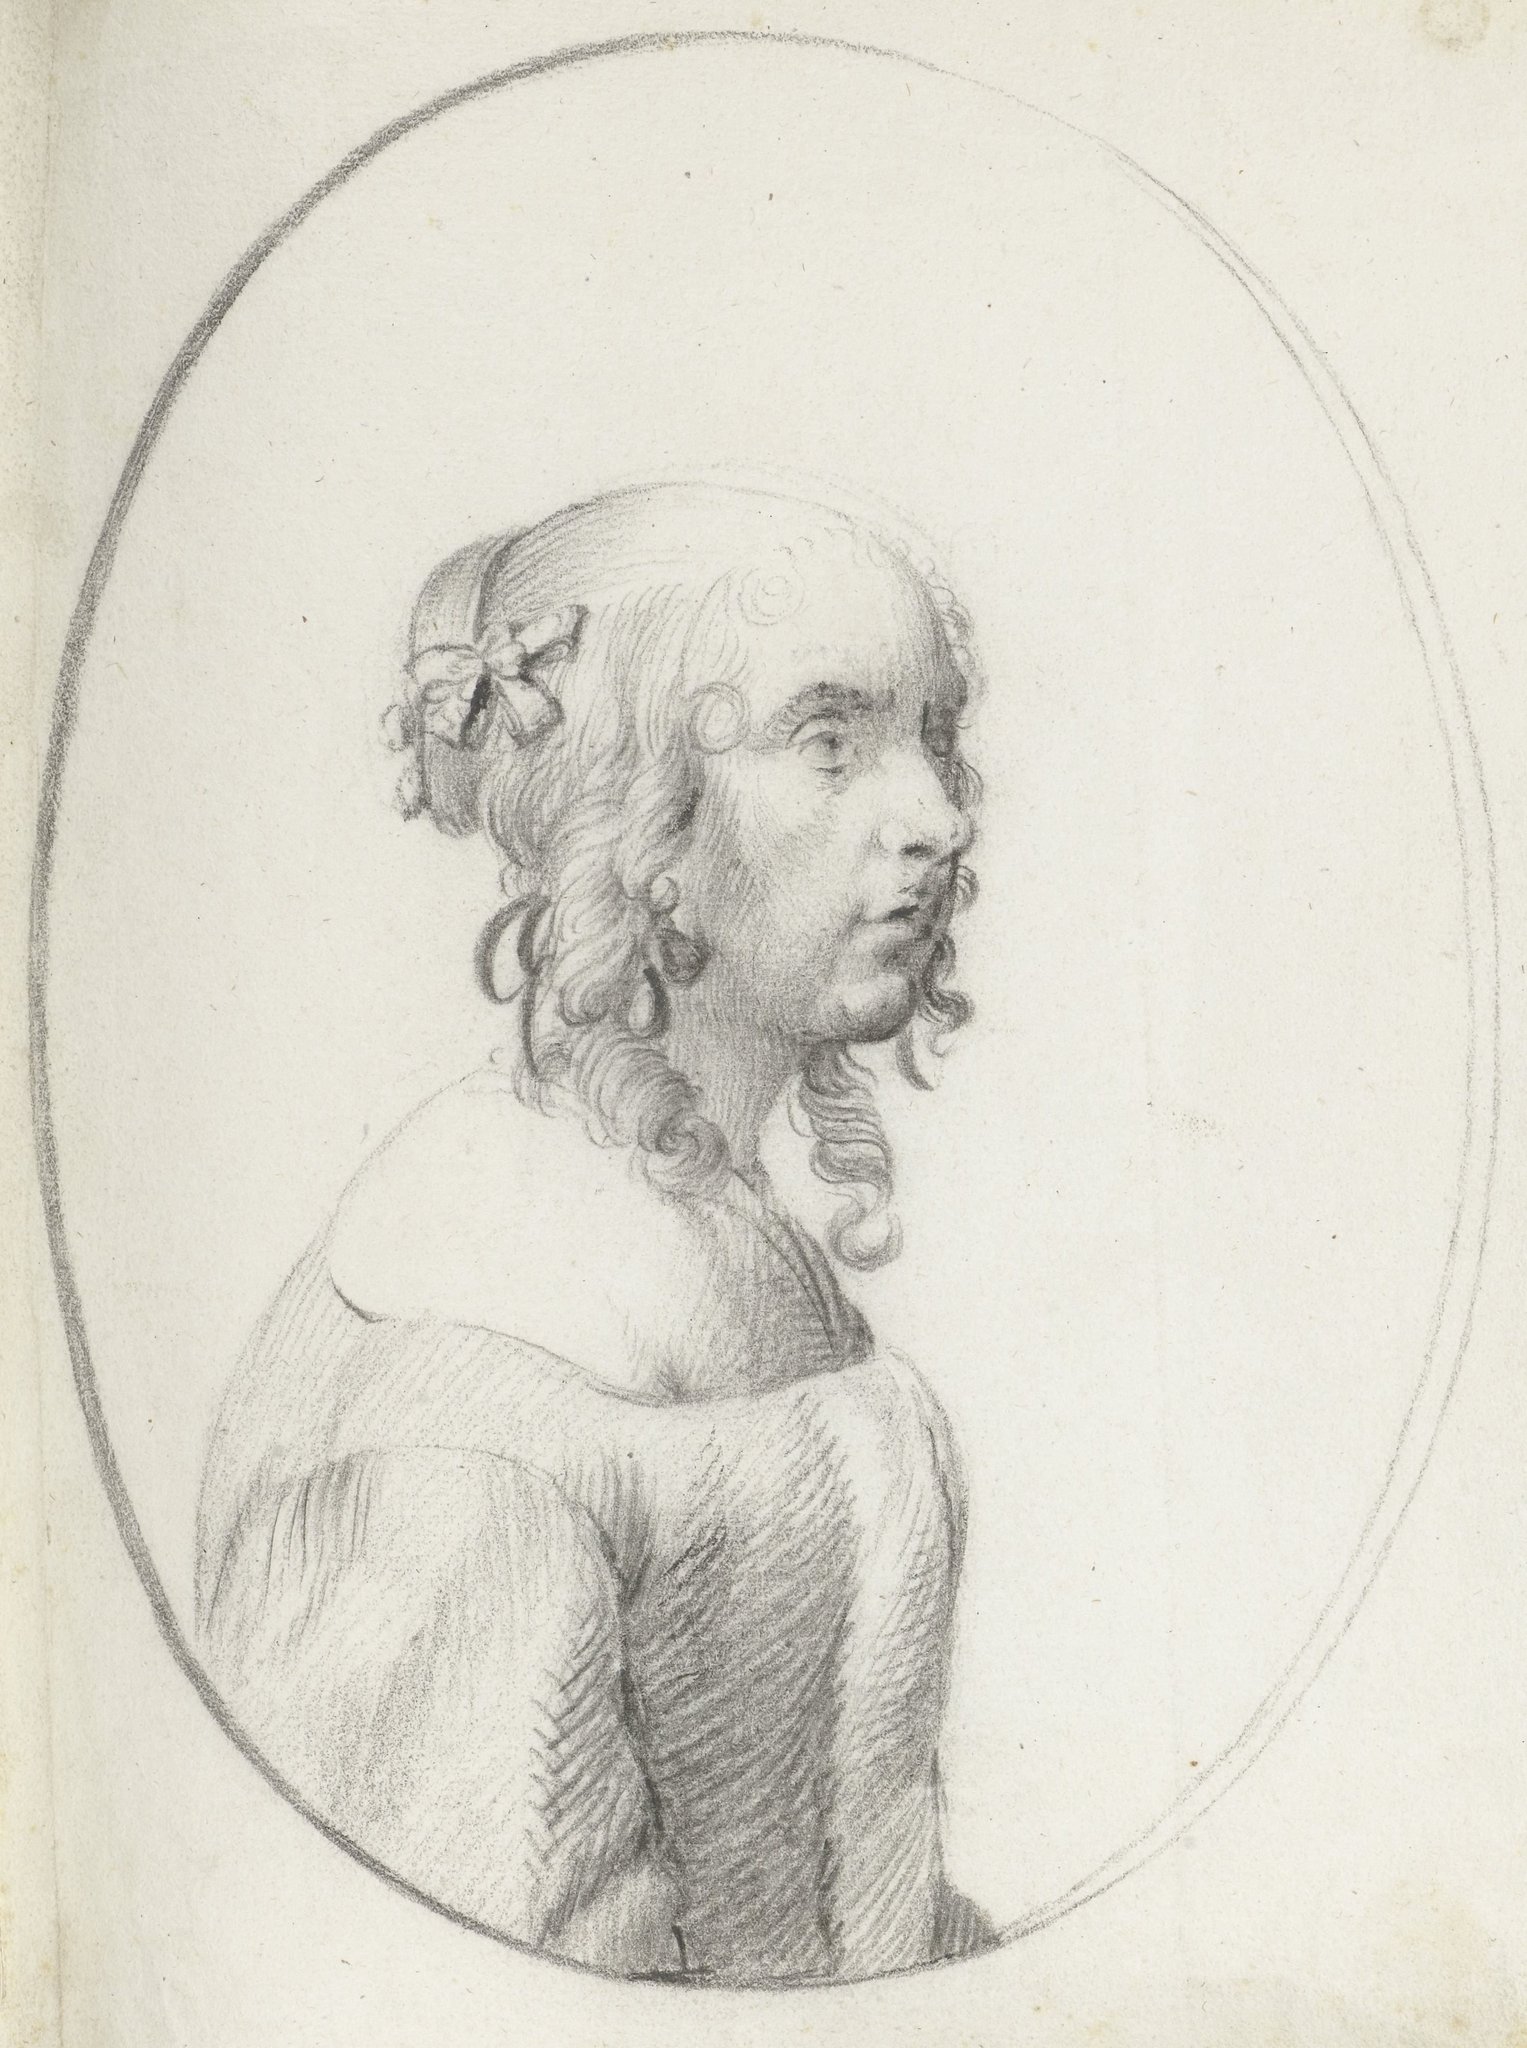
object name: drawing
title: Portret van een vrouw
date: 1643-1690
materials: chalk, paper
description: Tekening naast andere tekening opgeplakt in het Familie-plakboek.